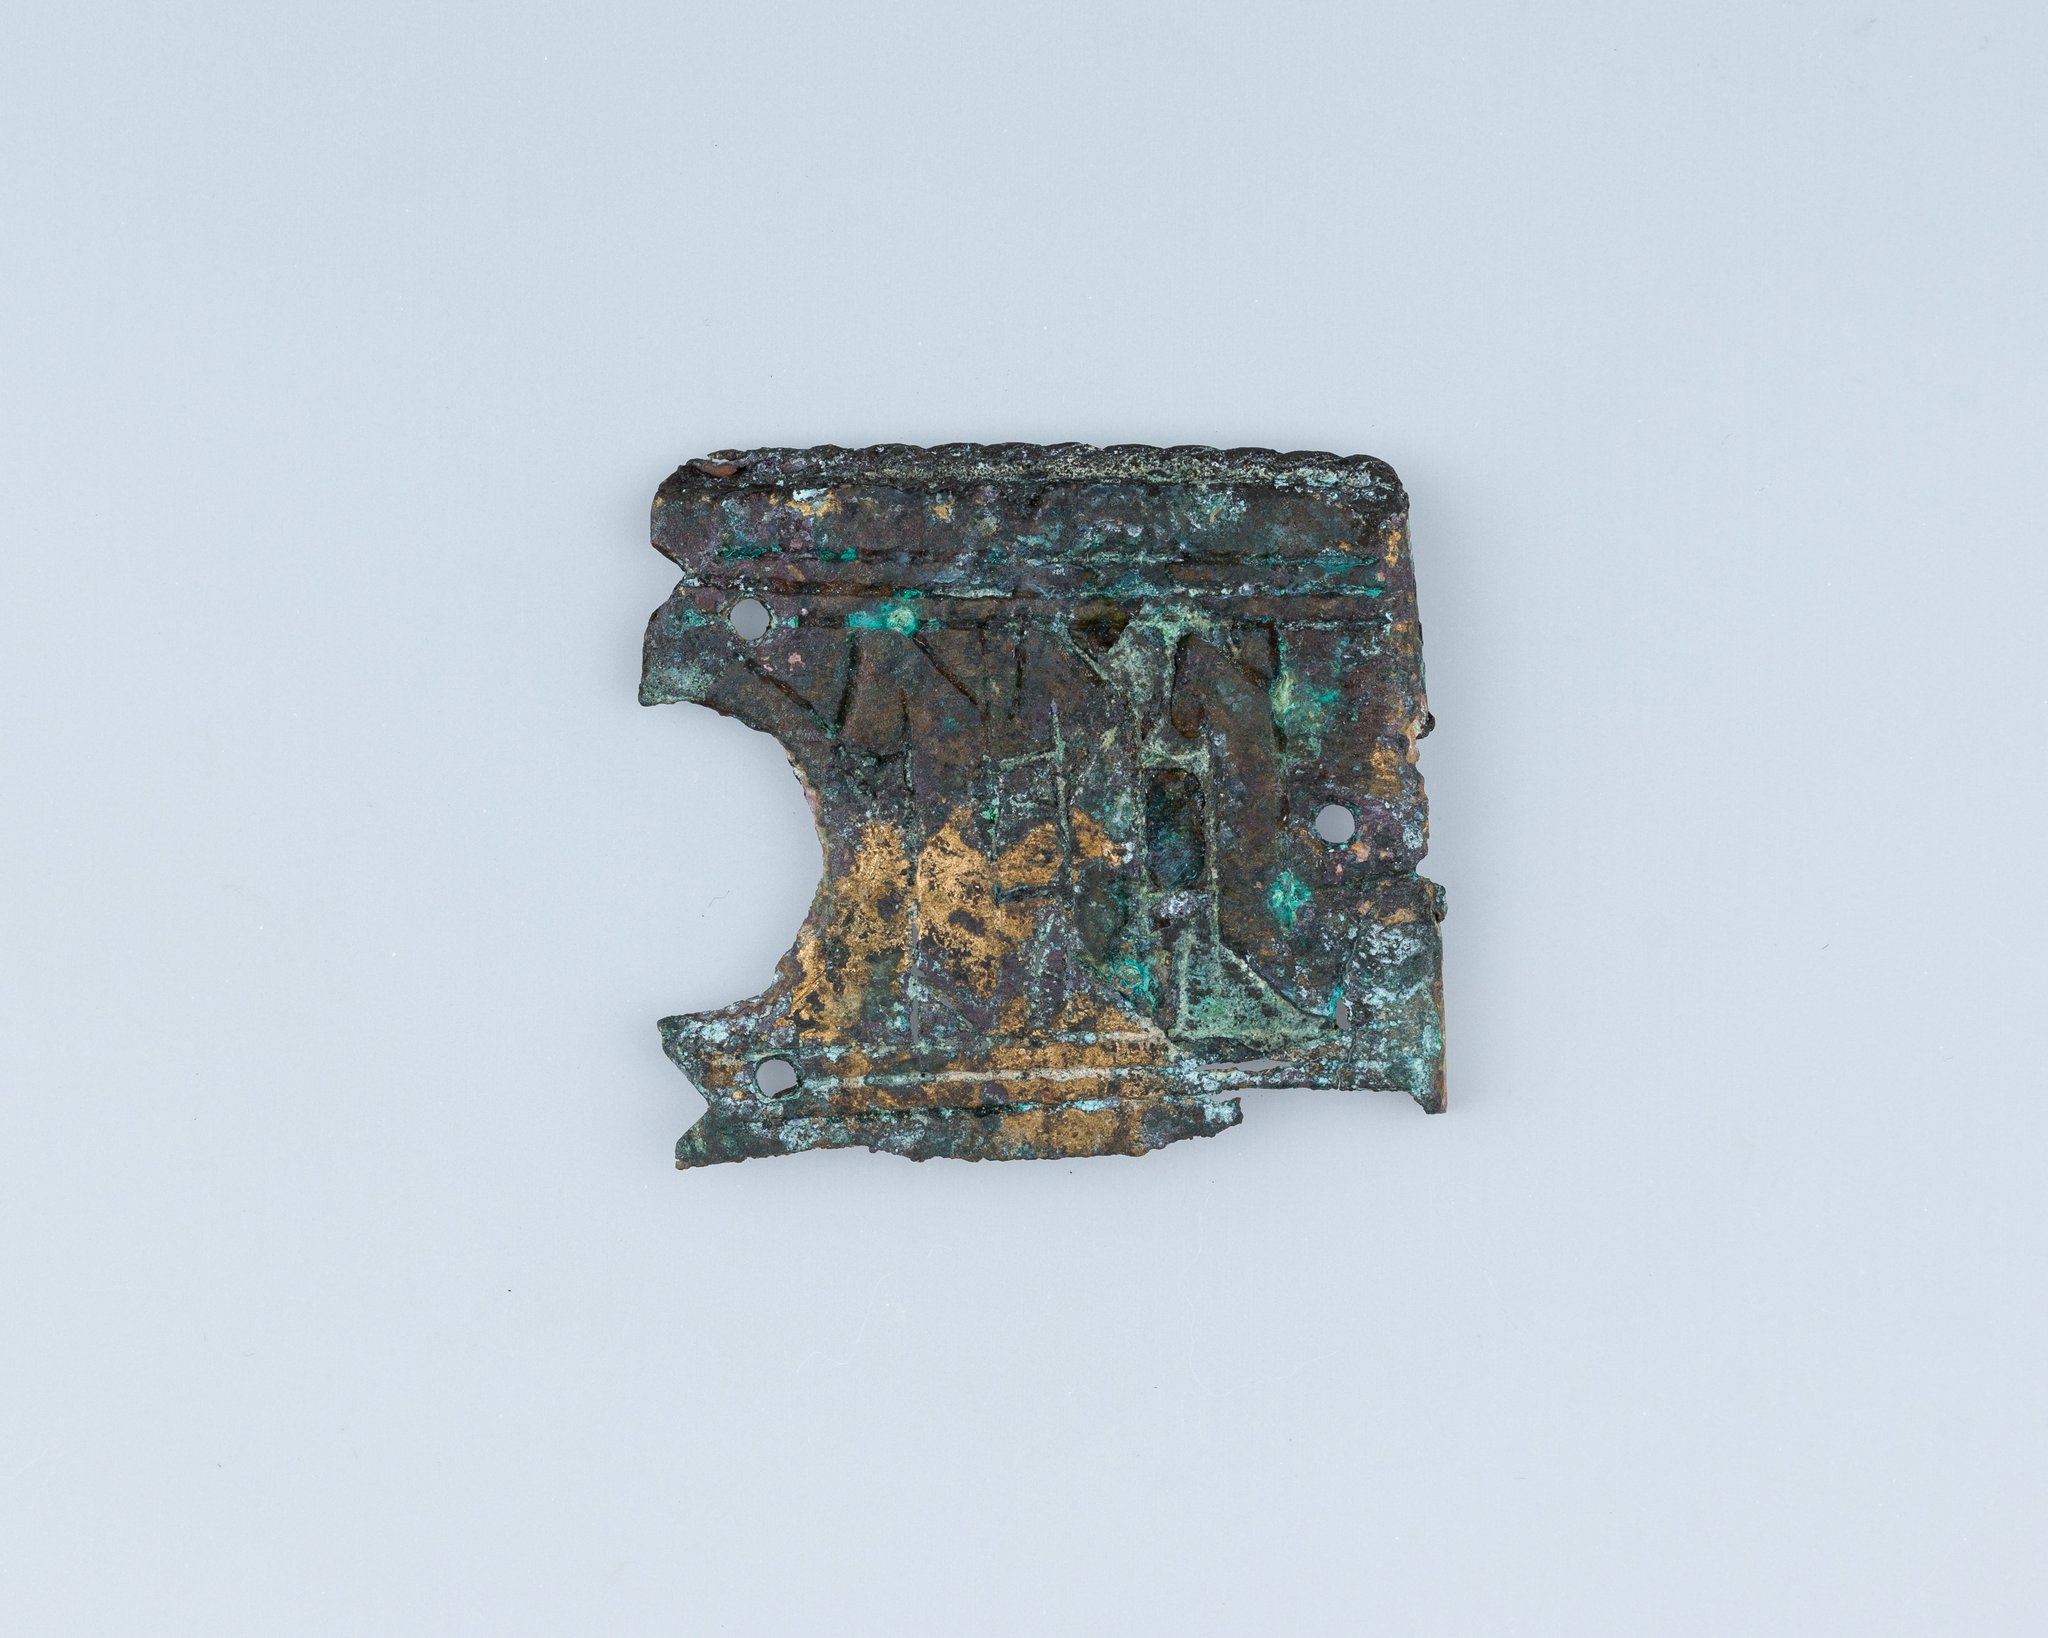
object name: buckle shank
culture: french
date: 1301-1400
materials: bronze, gilt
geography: france